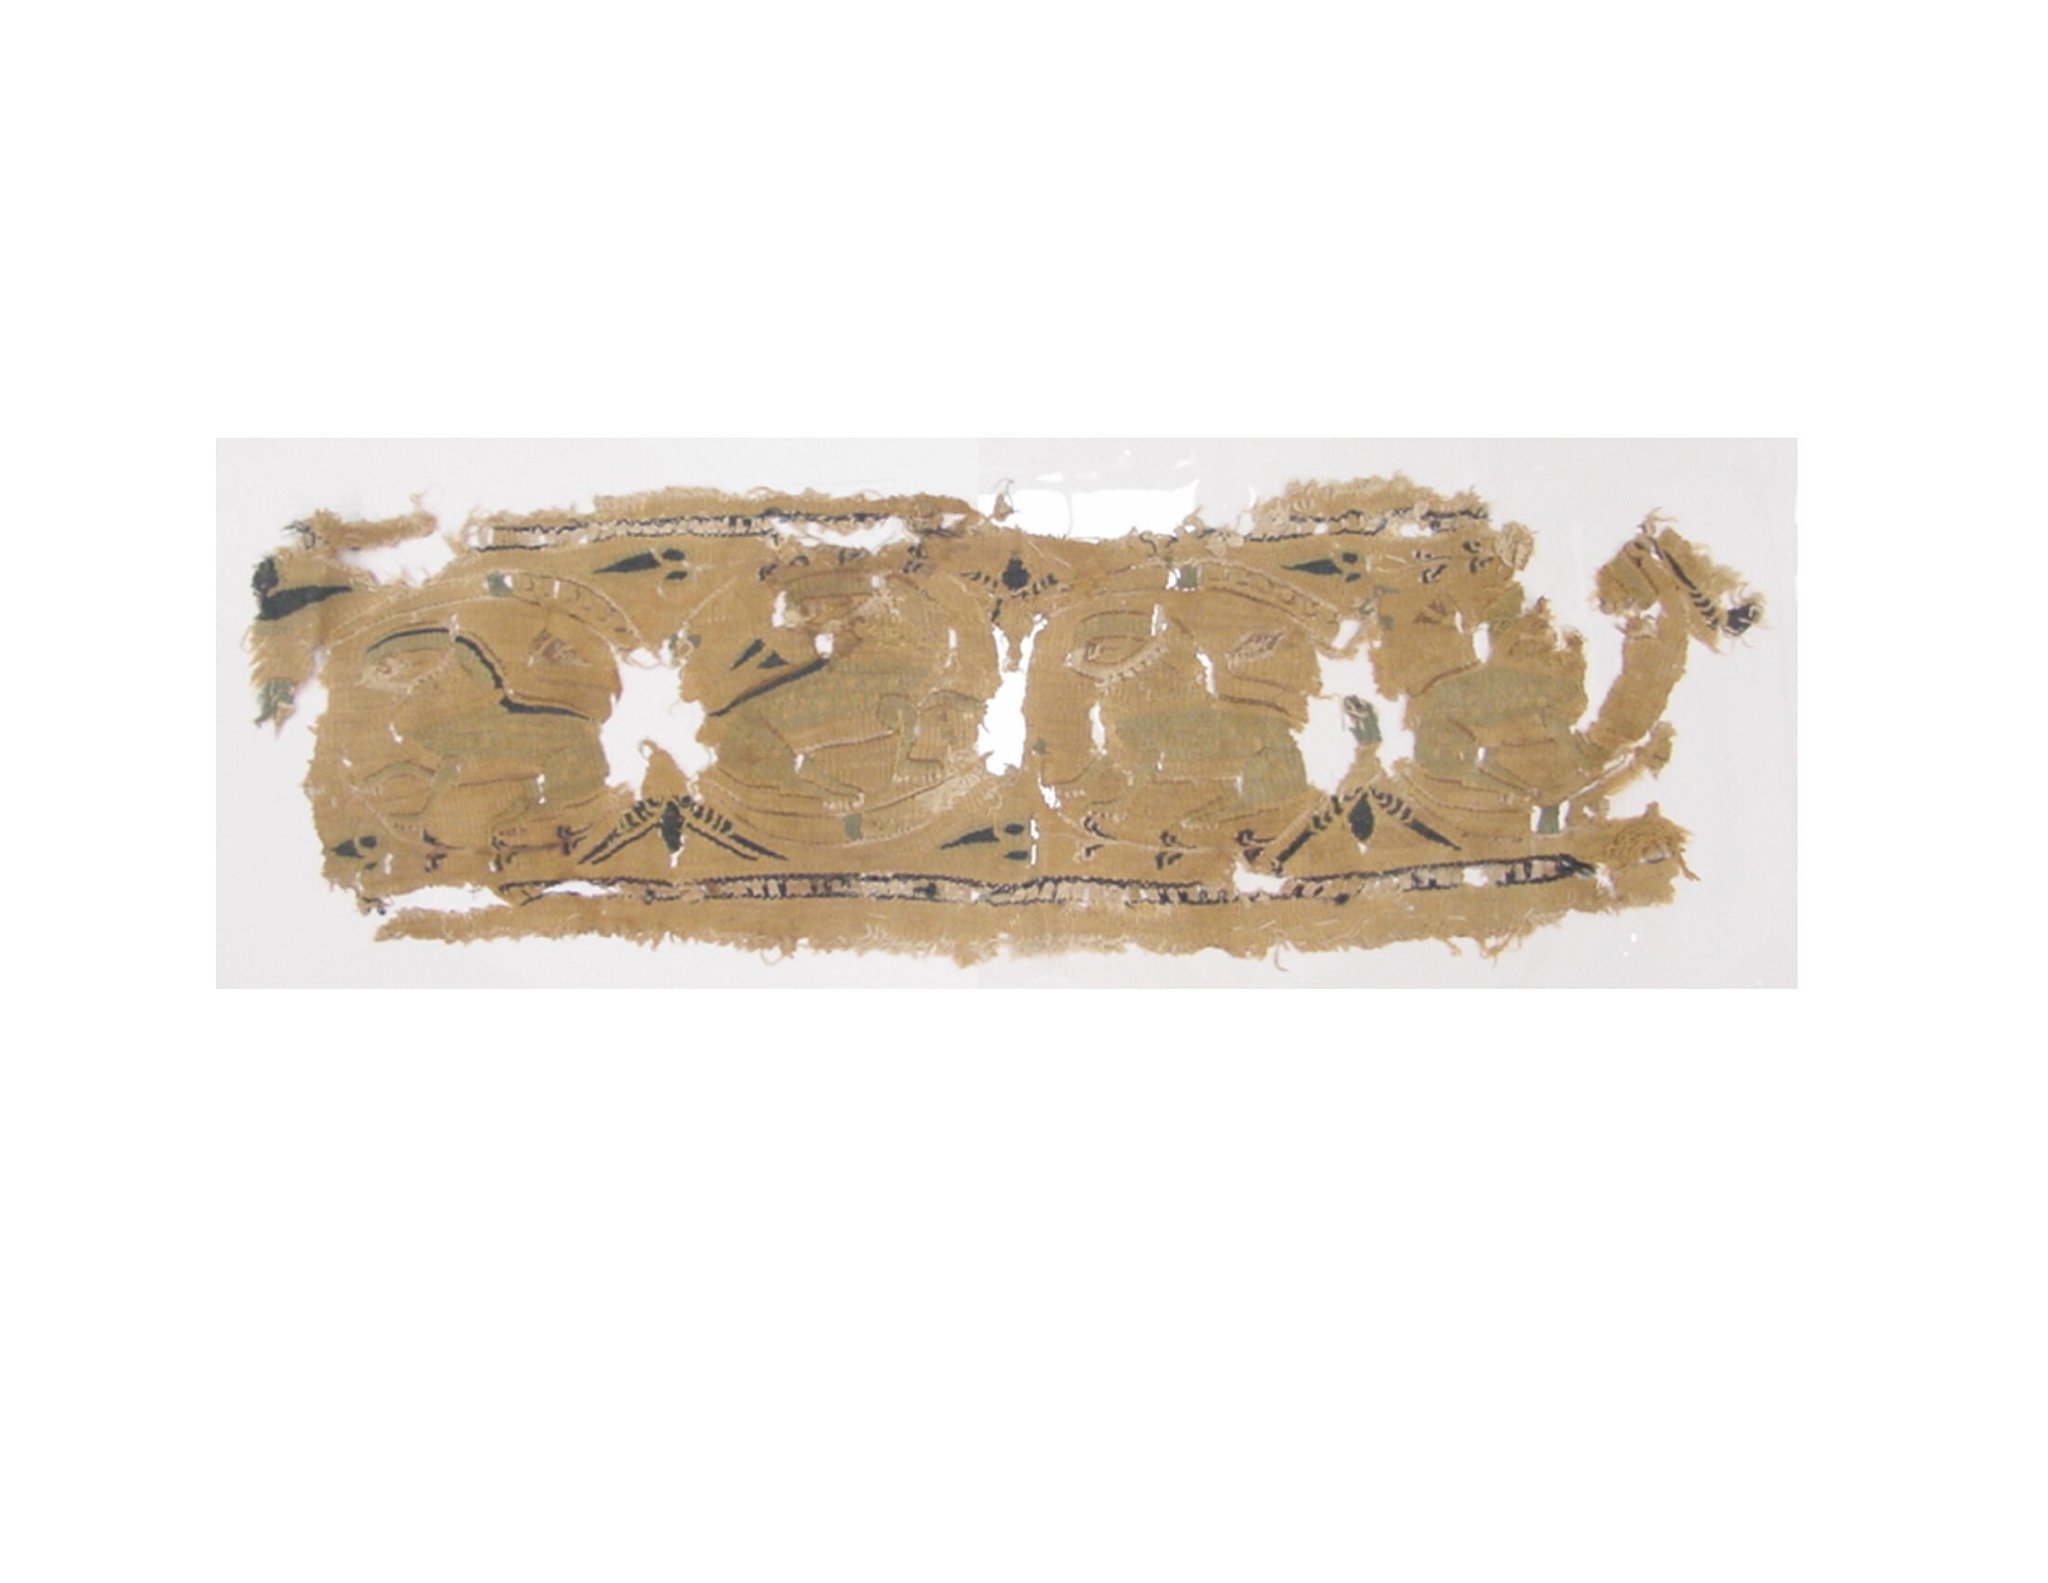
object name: textile fragment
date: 801-1000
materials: linen, wool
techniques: weave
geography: egypt